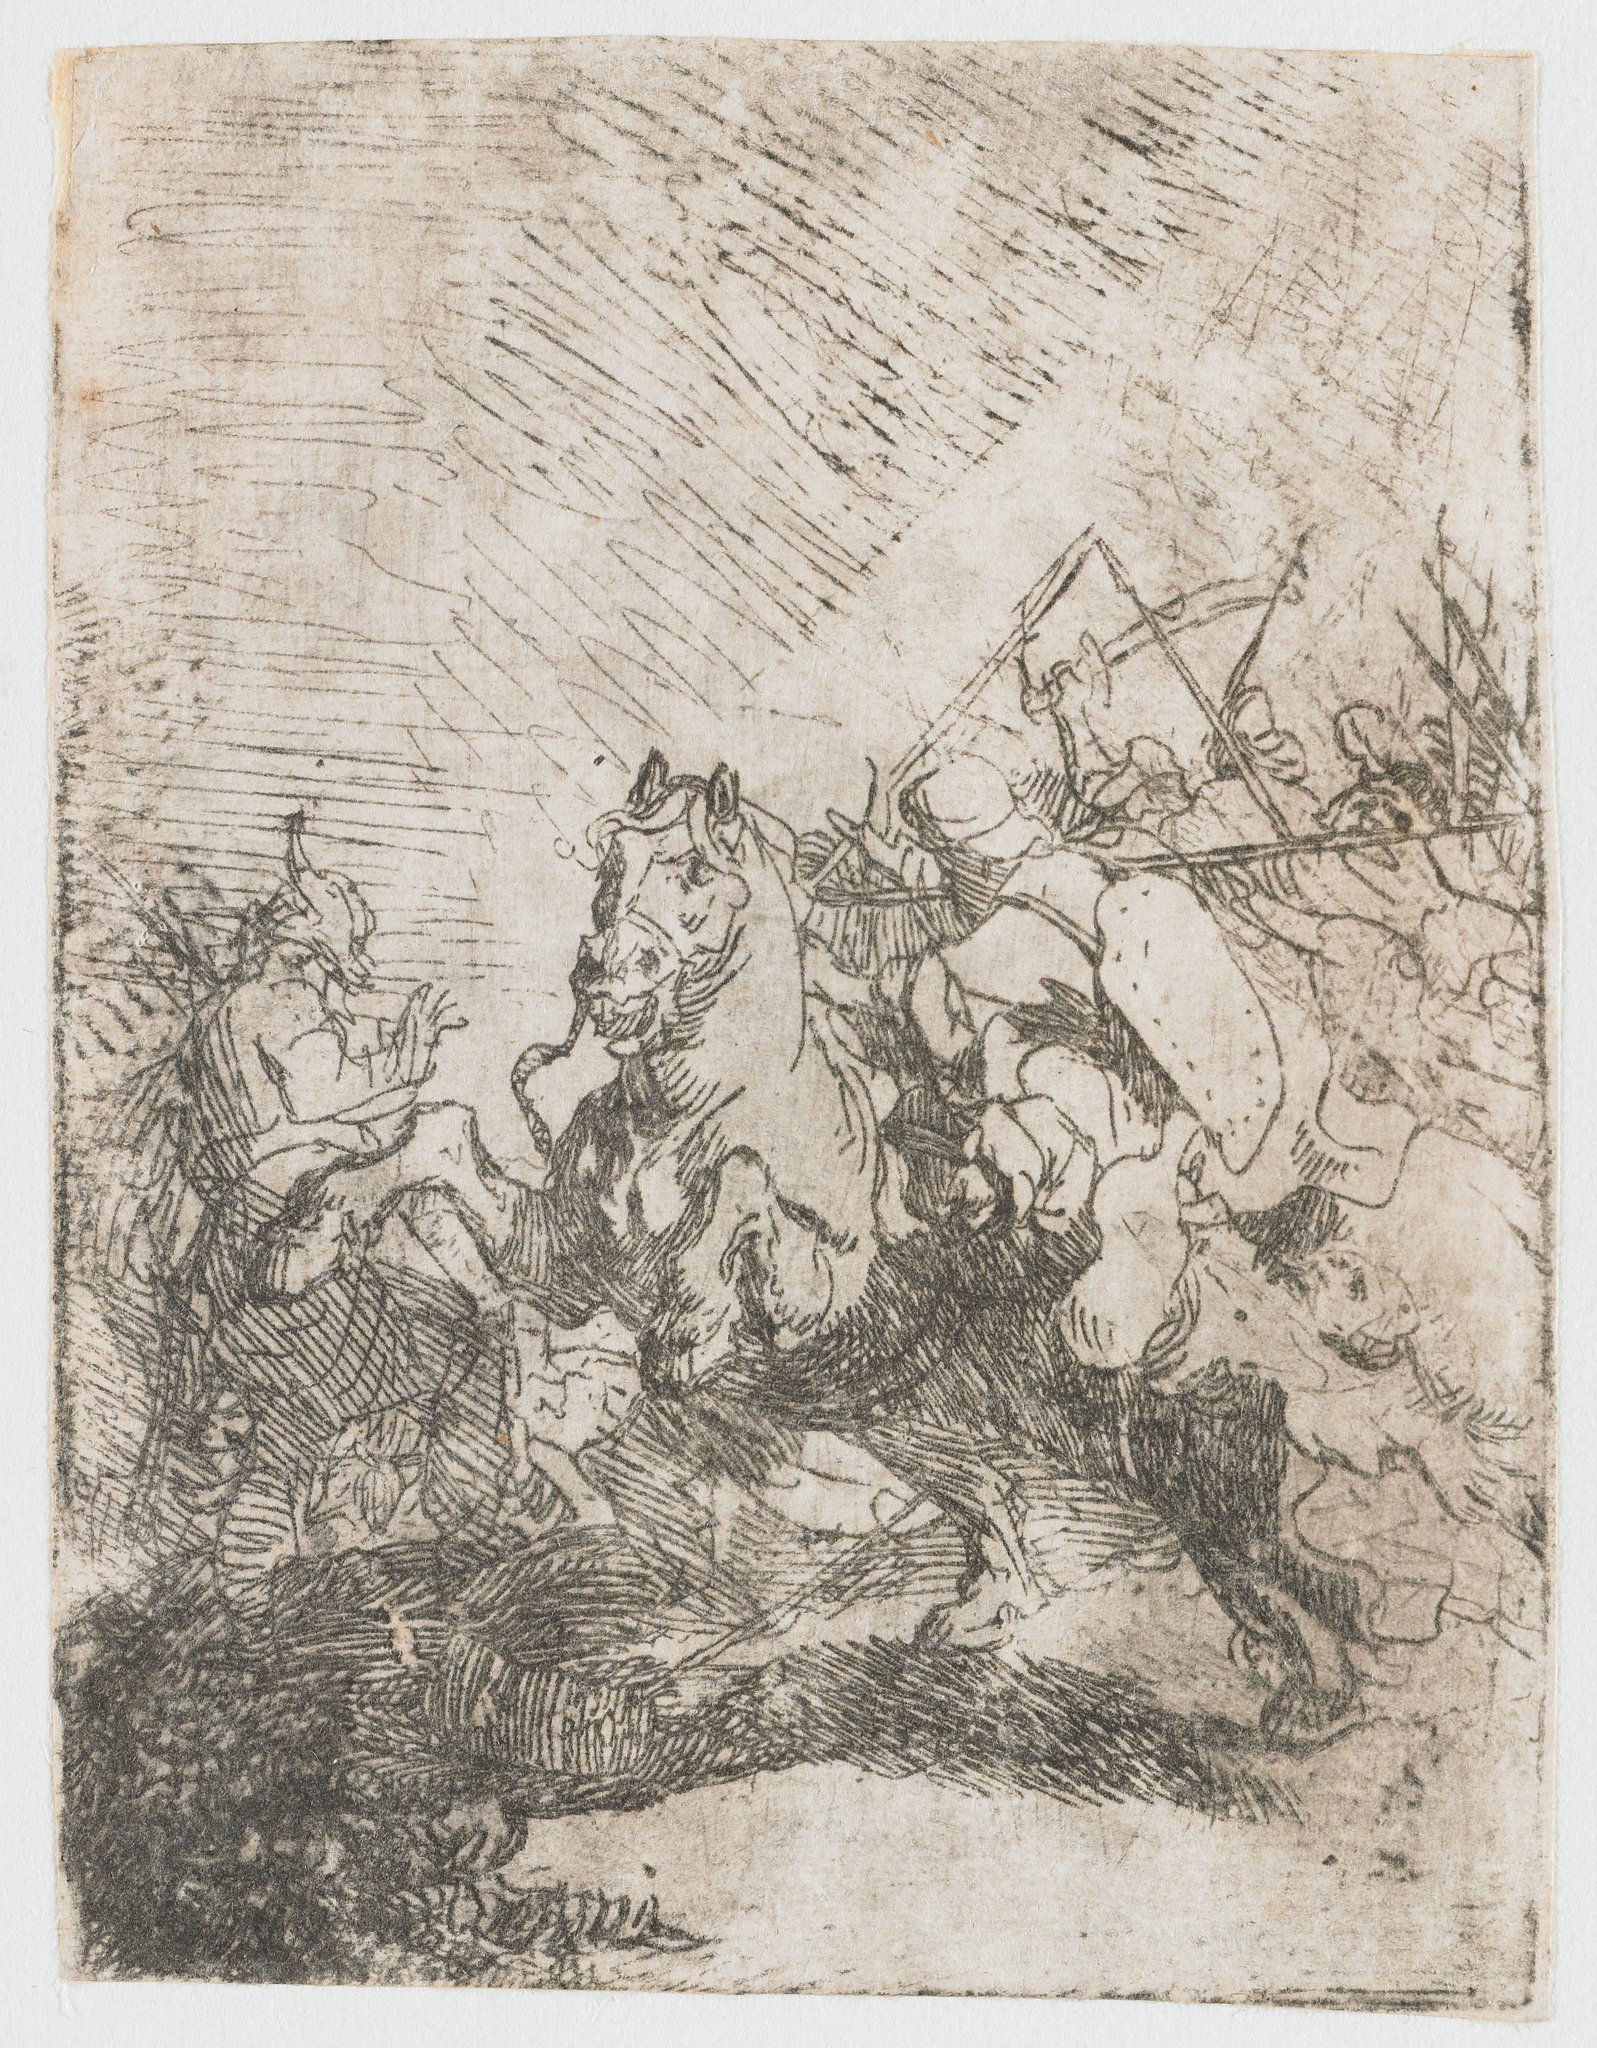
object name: print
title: A cavalry fight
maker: rembrandt van rijn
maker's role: draughtsman, painter, print maker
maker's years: 1606-1669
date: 1629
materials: paper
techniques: etching, intaglio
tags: warfare; military affairs (+ cavalry, horsemen)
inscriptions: collector's mark: Lugt 240